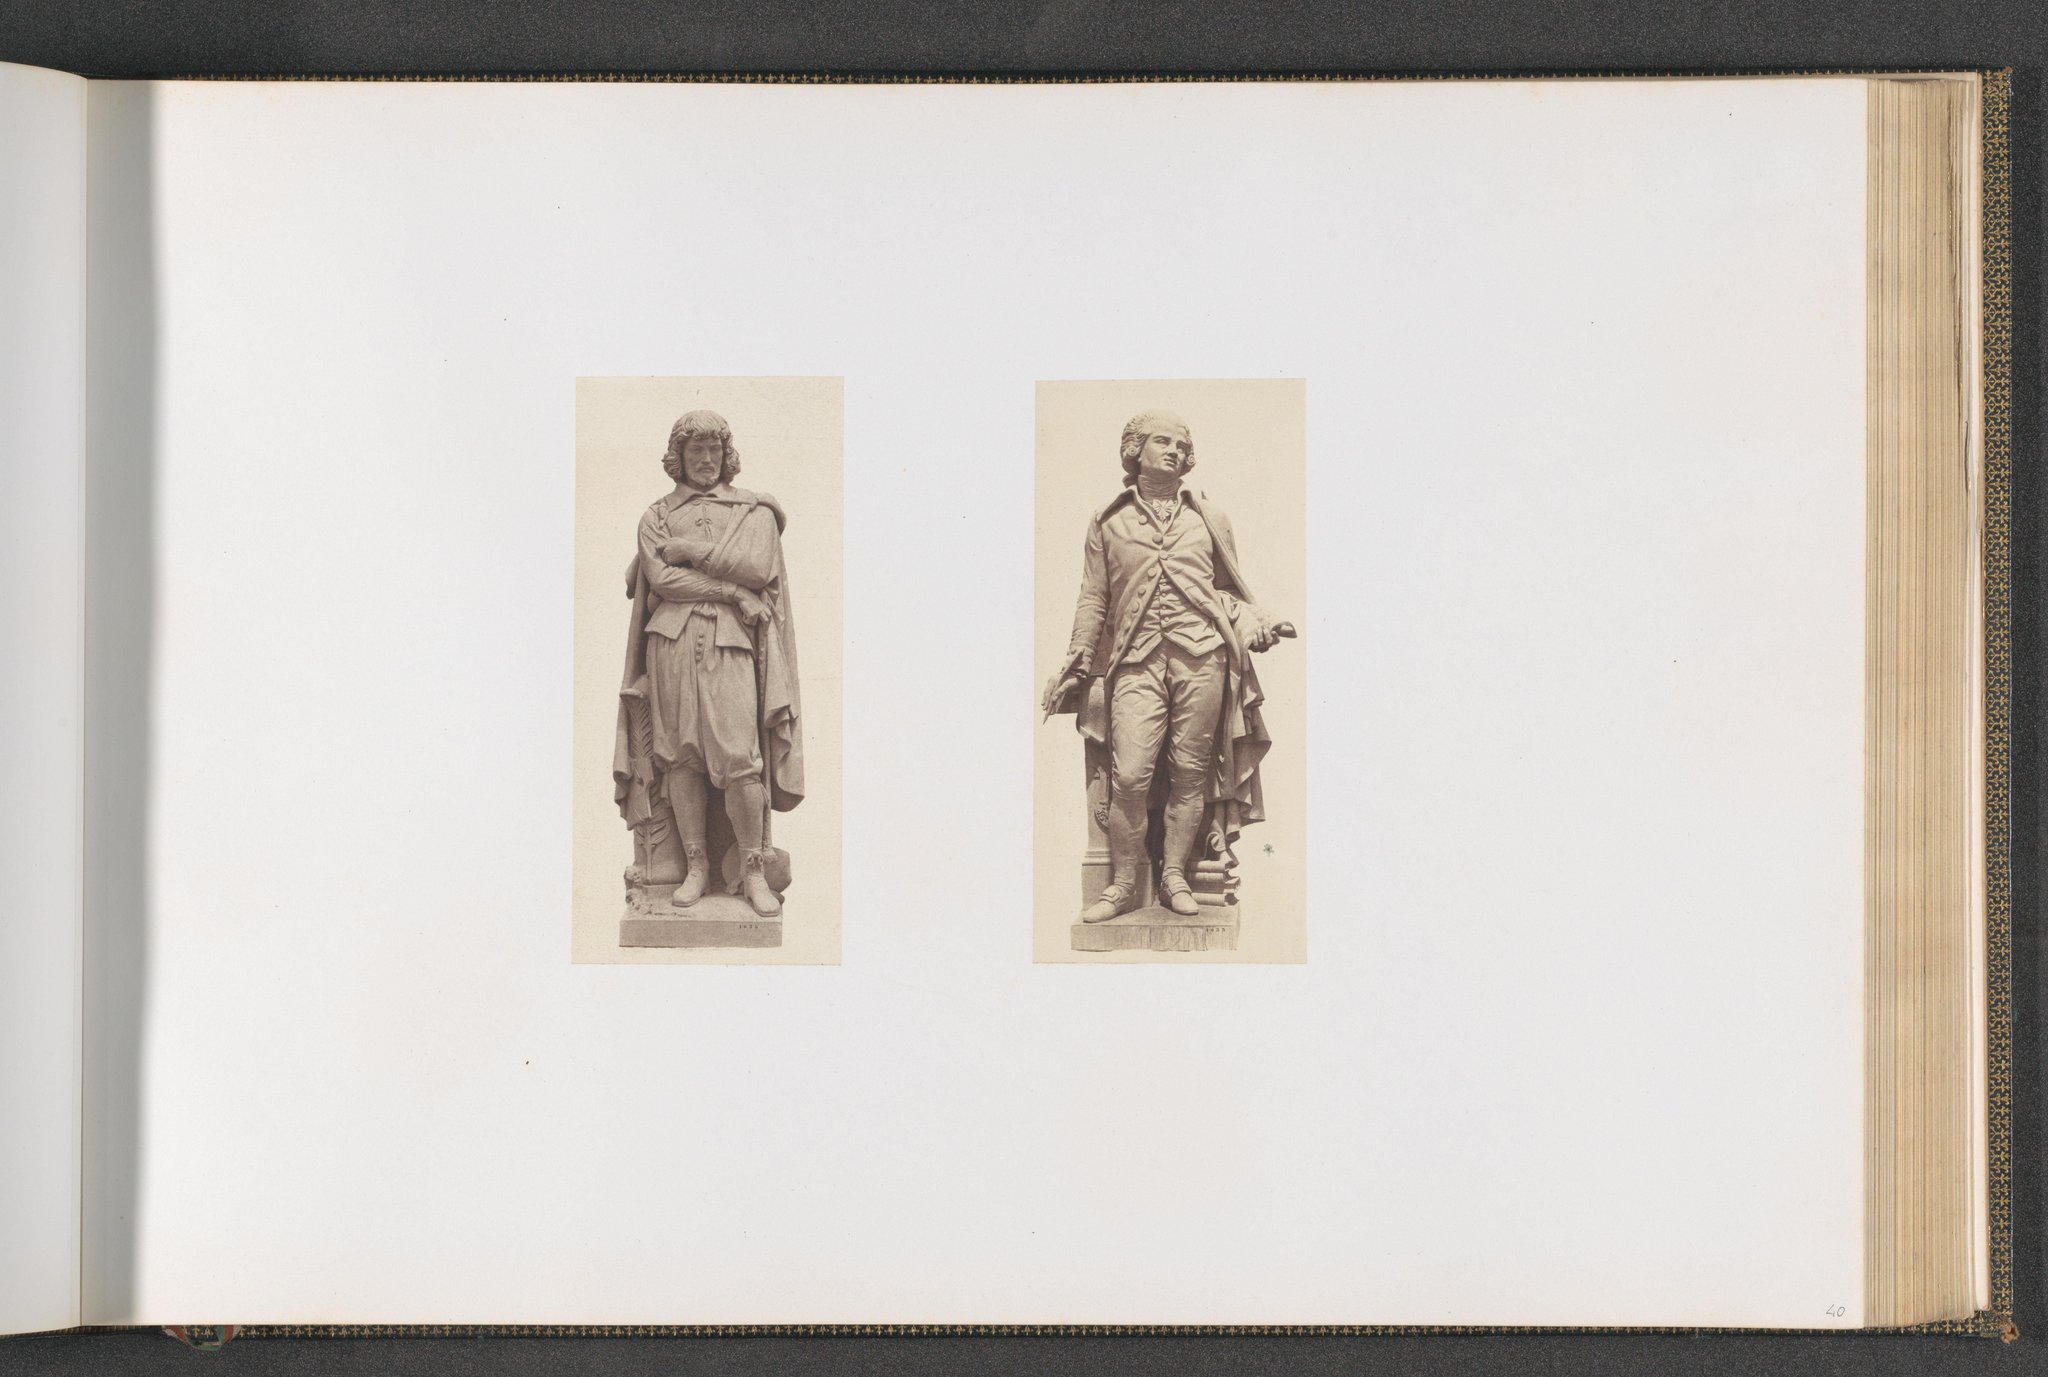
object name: album leaf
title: Gipsmodellen voor beeldhouwwerken op het Palais du Louvre: links "Le Lorrain" door Auguste Hyacinthe Debay en rechts "Grétry" door Victor Vilain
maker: édouard denis baldus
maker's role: fotograaf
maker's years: 1813-1889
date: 1855-1857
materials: paper, photographic support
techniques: salted paper print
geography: paris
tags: piece of sculpture, reproduction of a piece of sculpture, permanent exhibition, museum, paris, tuileries palace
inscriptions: number: ‘1035 en 1033’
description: Onderdeel van Réunion des Tuileries au Louvre 1852-1857, album 2.